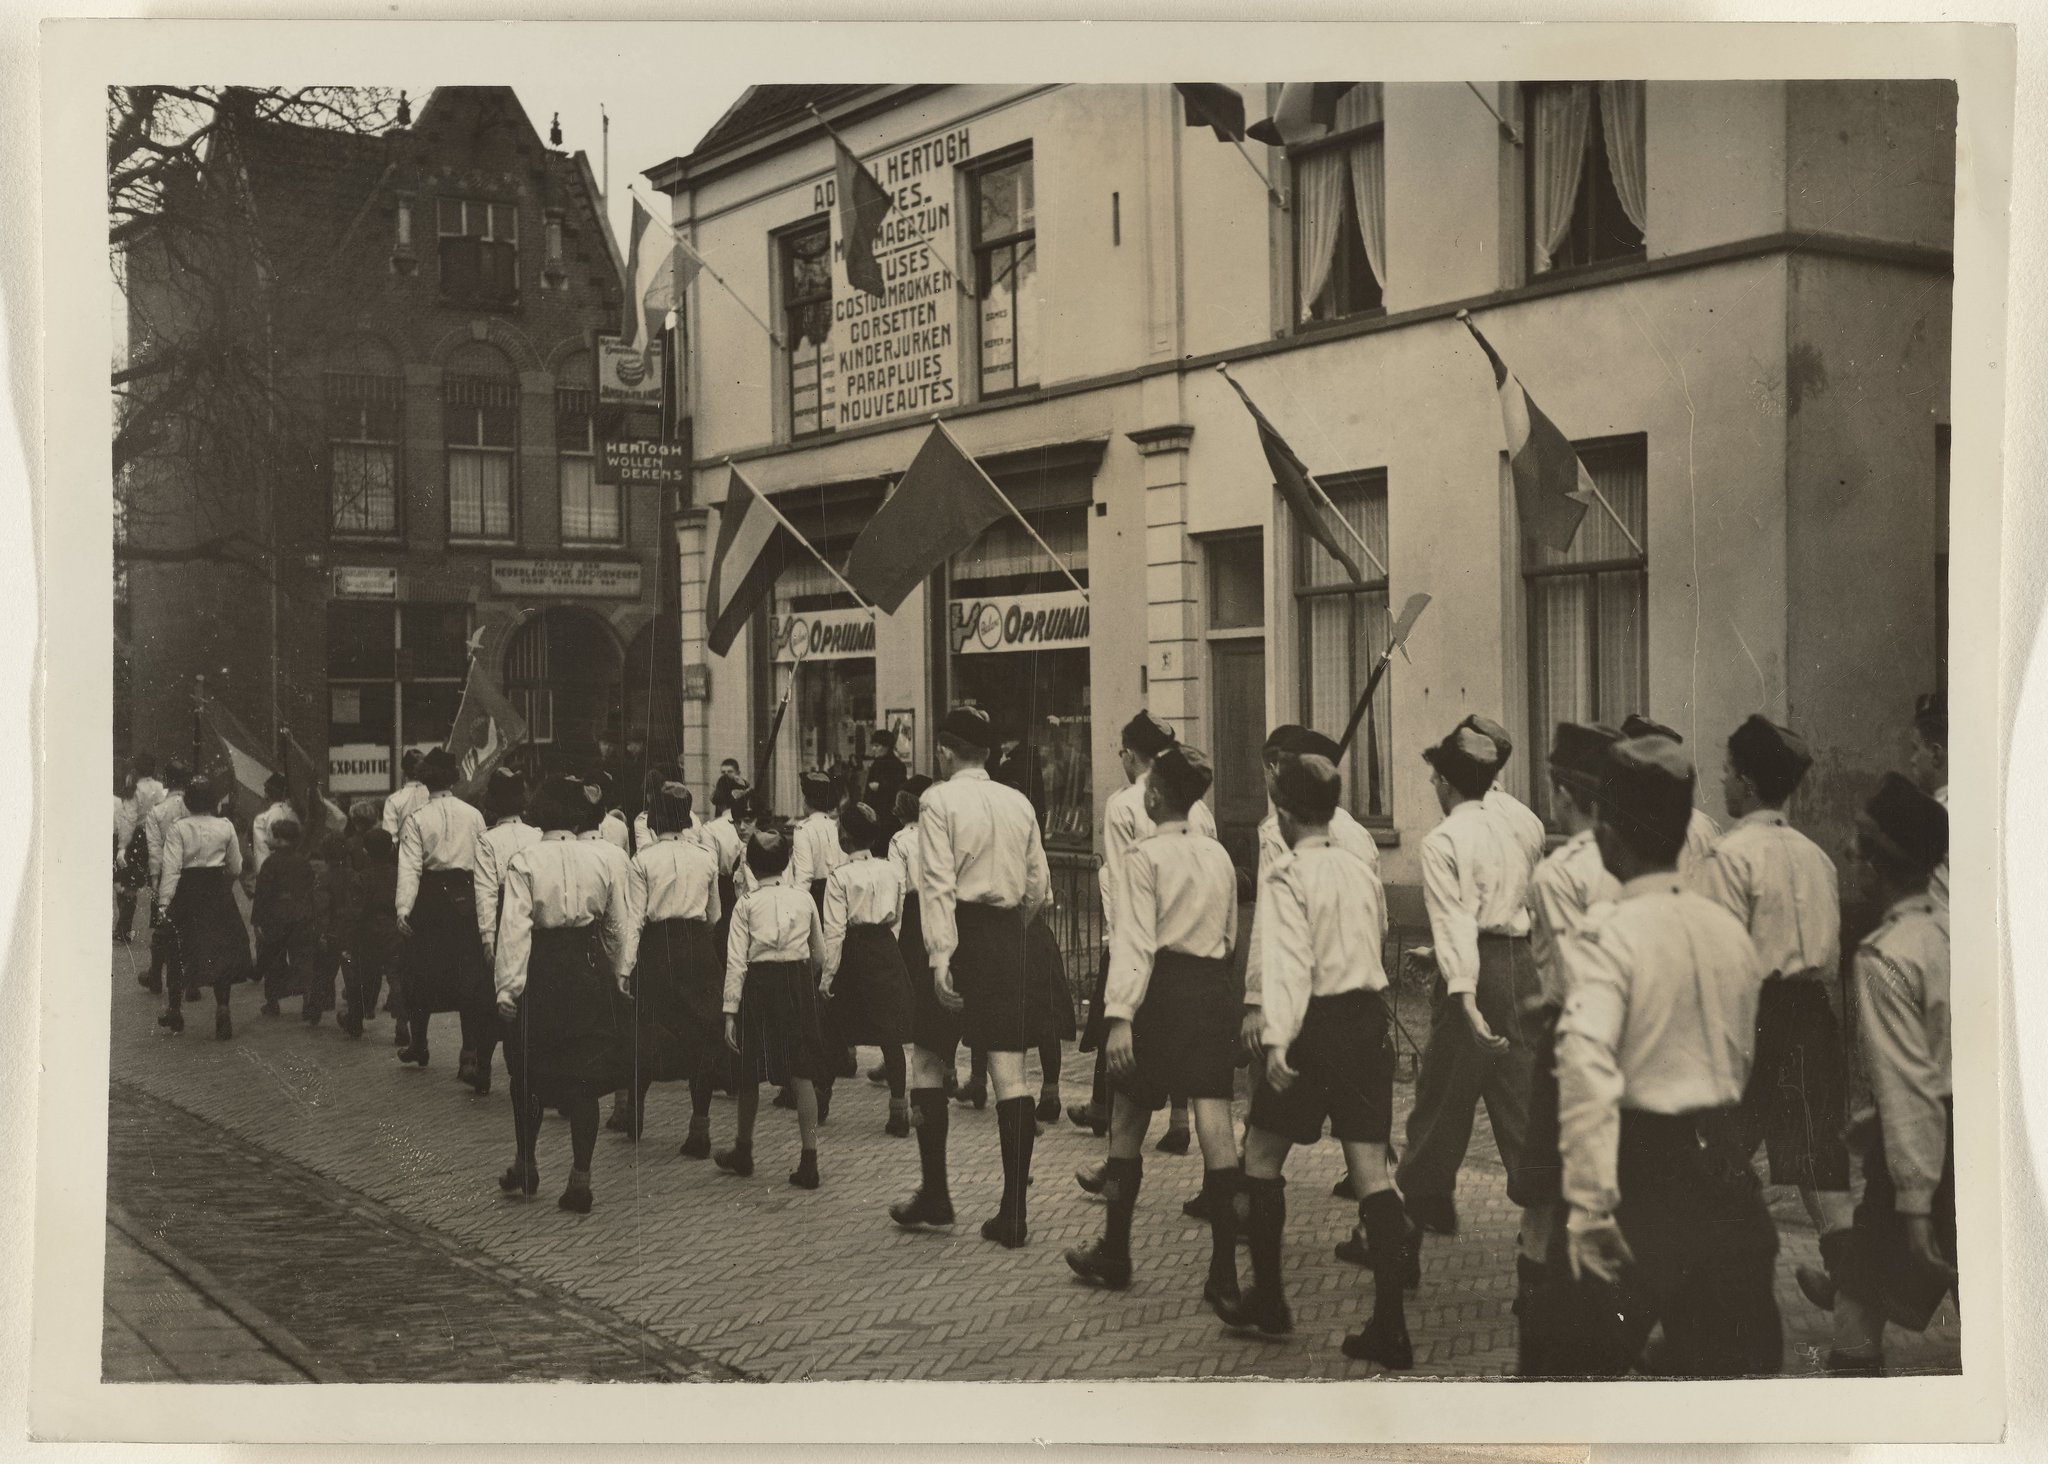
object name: photograph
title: Optocht van de Nationale Jeugdstorm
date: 1938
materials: photographic support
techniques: photography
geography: baarn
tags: the hague, juliana of the netherlands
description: Een oefen-optocht van kinderen op de rug gezien, door de straten van Baarn. De kinderen zijn lid van de Jeugdstorm, de jeugdafdeling van de NSB.